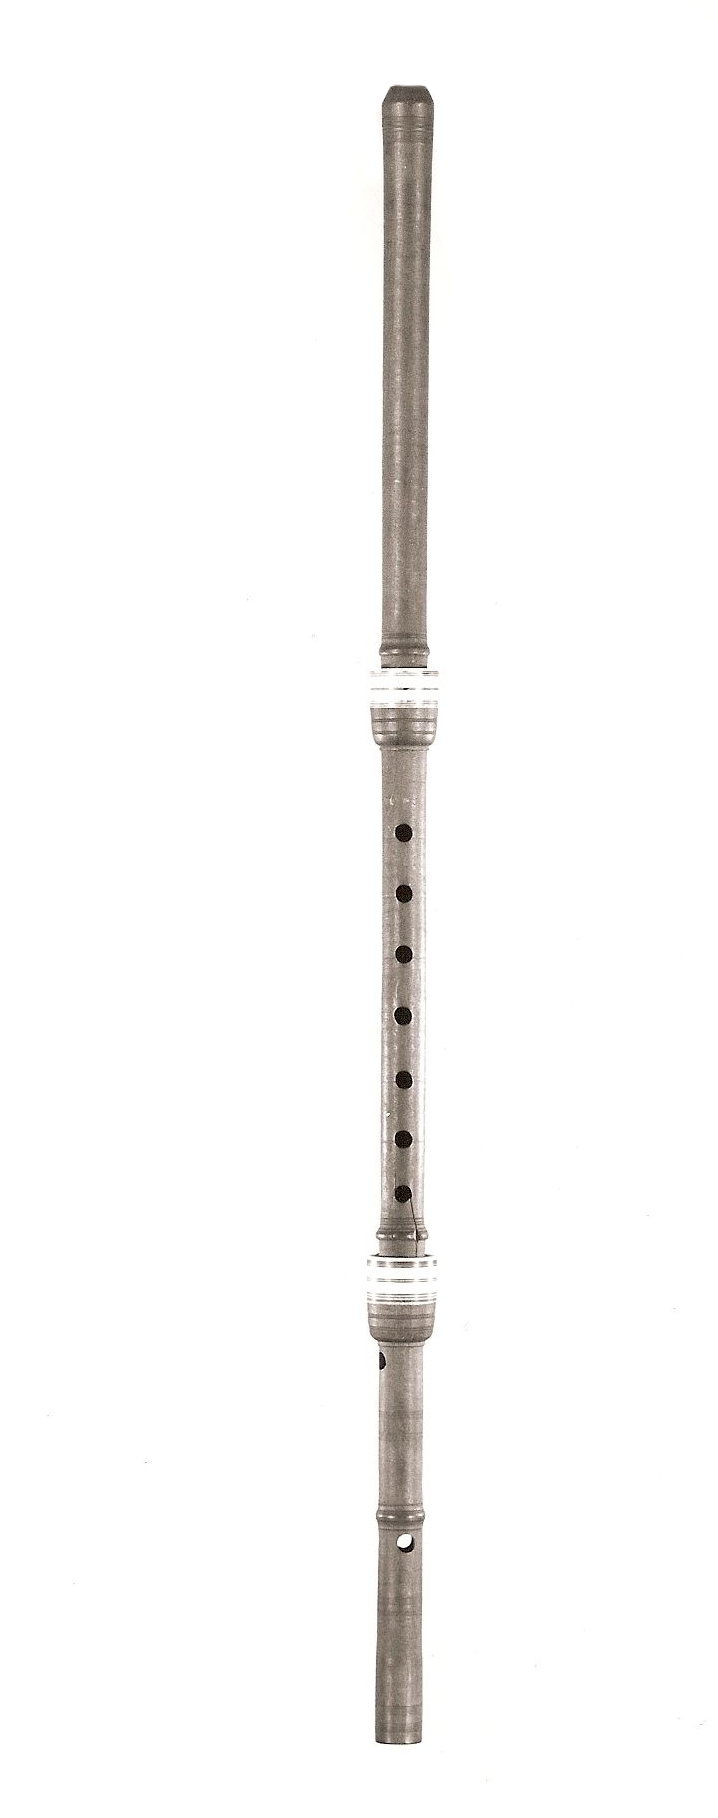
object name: kaval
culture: bulgarian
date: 1867-1900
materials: wood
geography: bulgaria